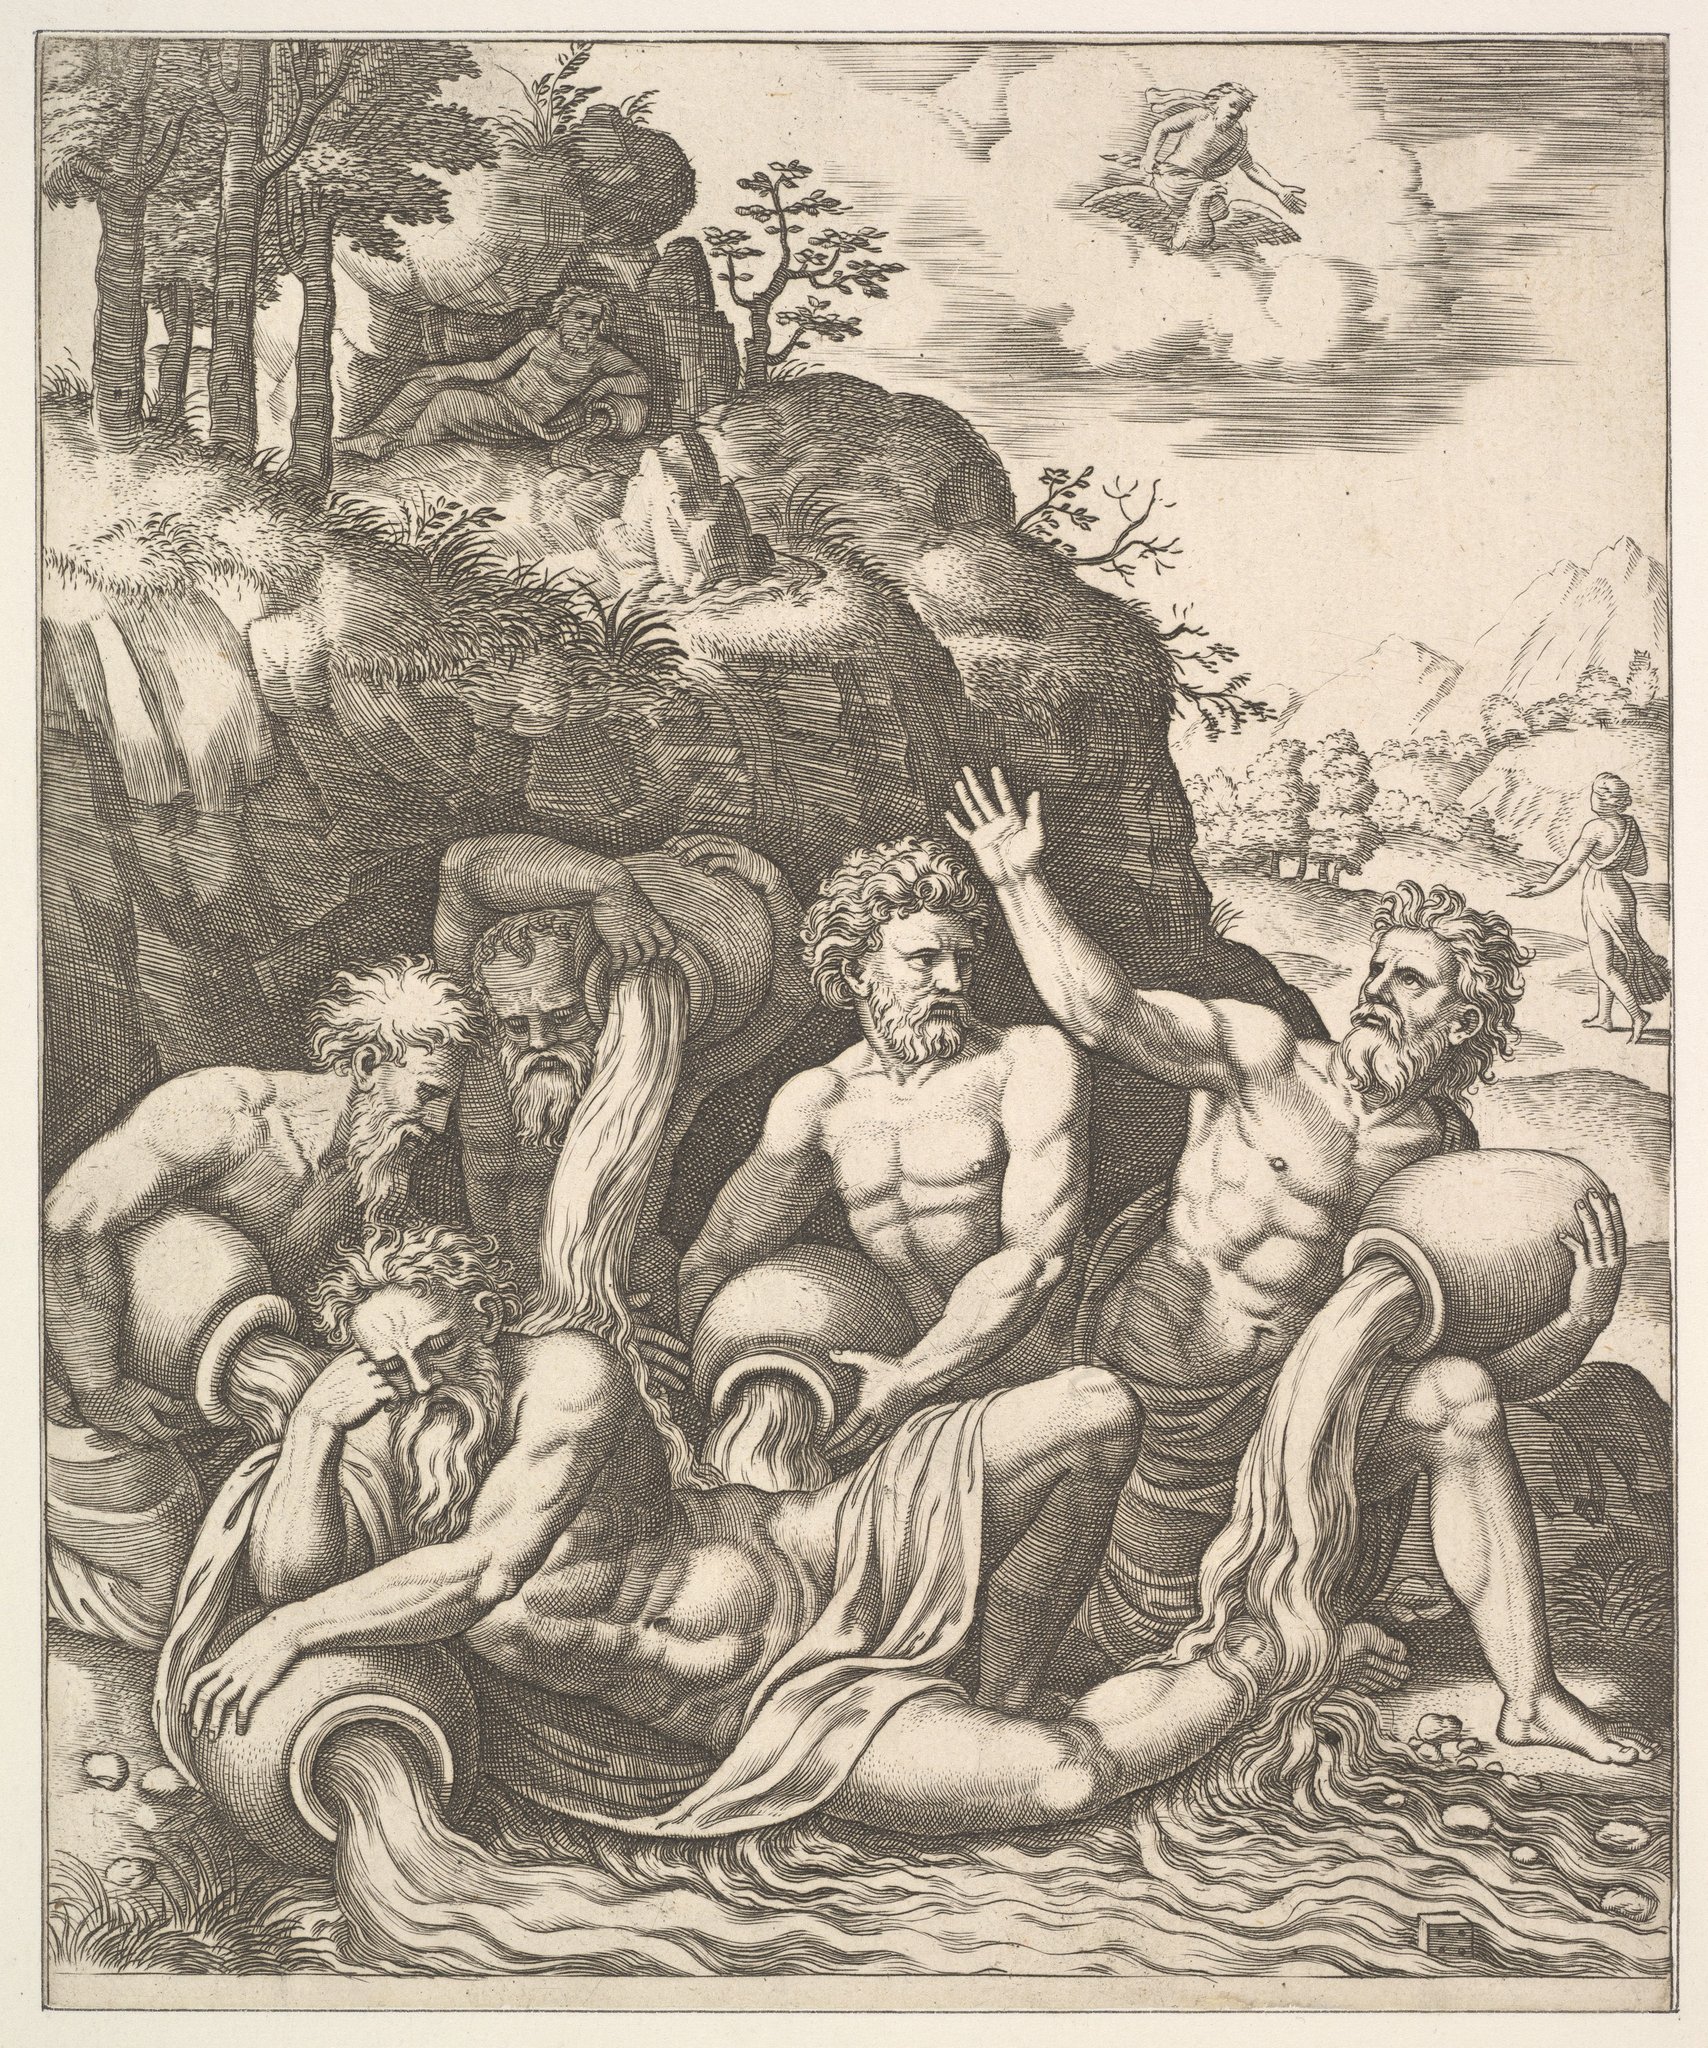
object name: print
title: River gods consoling Peneus for the Loss of his Daughter, Daphne from 'The Story of Apollo and Daphne'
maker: master of the die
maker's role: artist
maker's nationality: italian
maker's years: 1525-1560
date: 1530-1560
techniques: engraving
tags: mythology,men